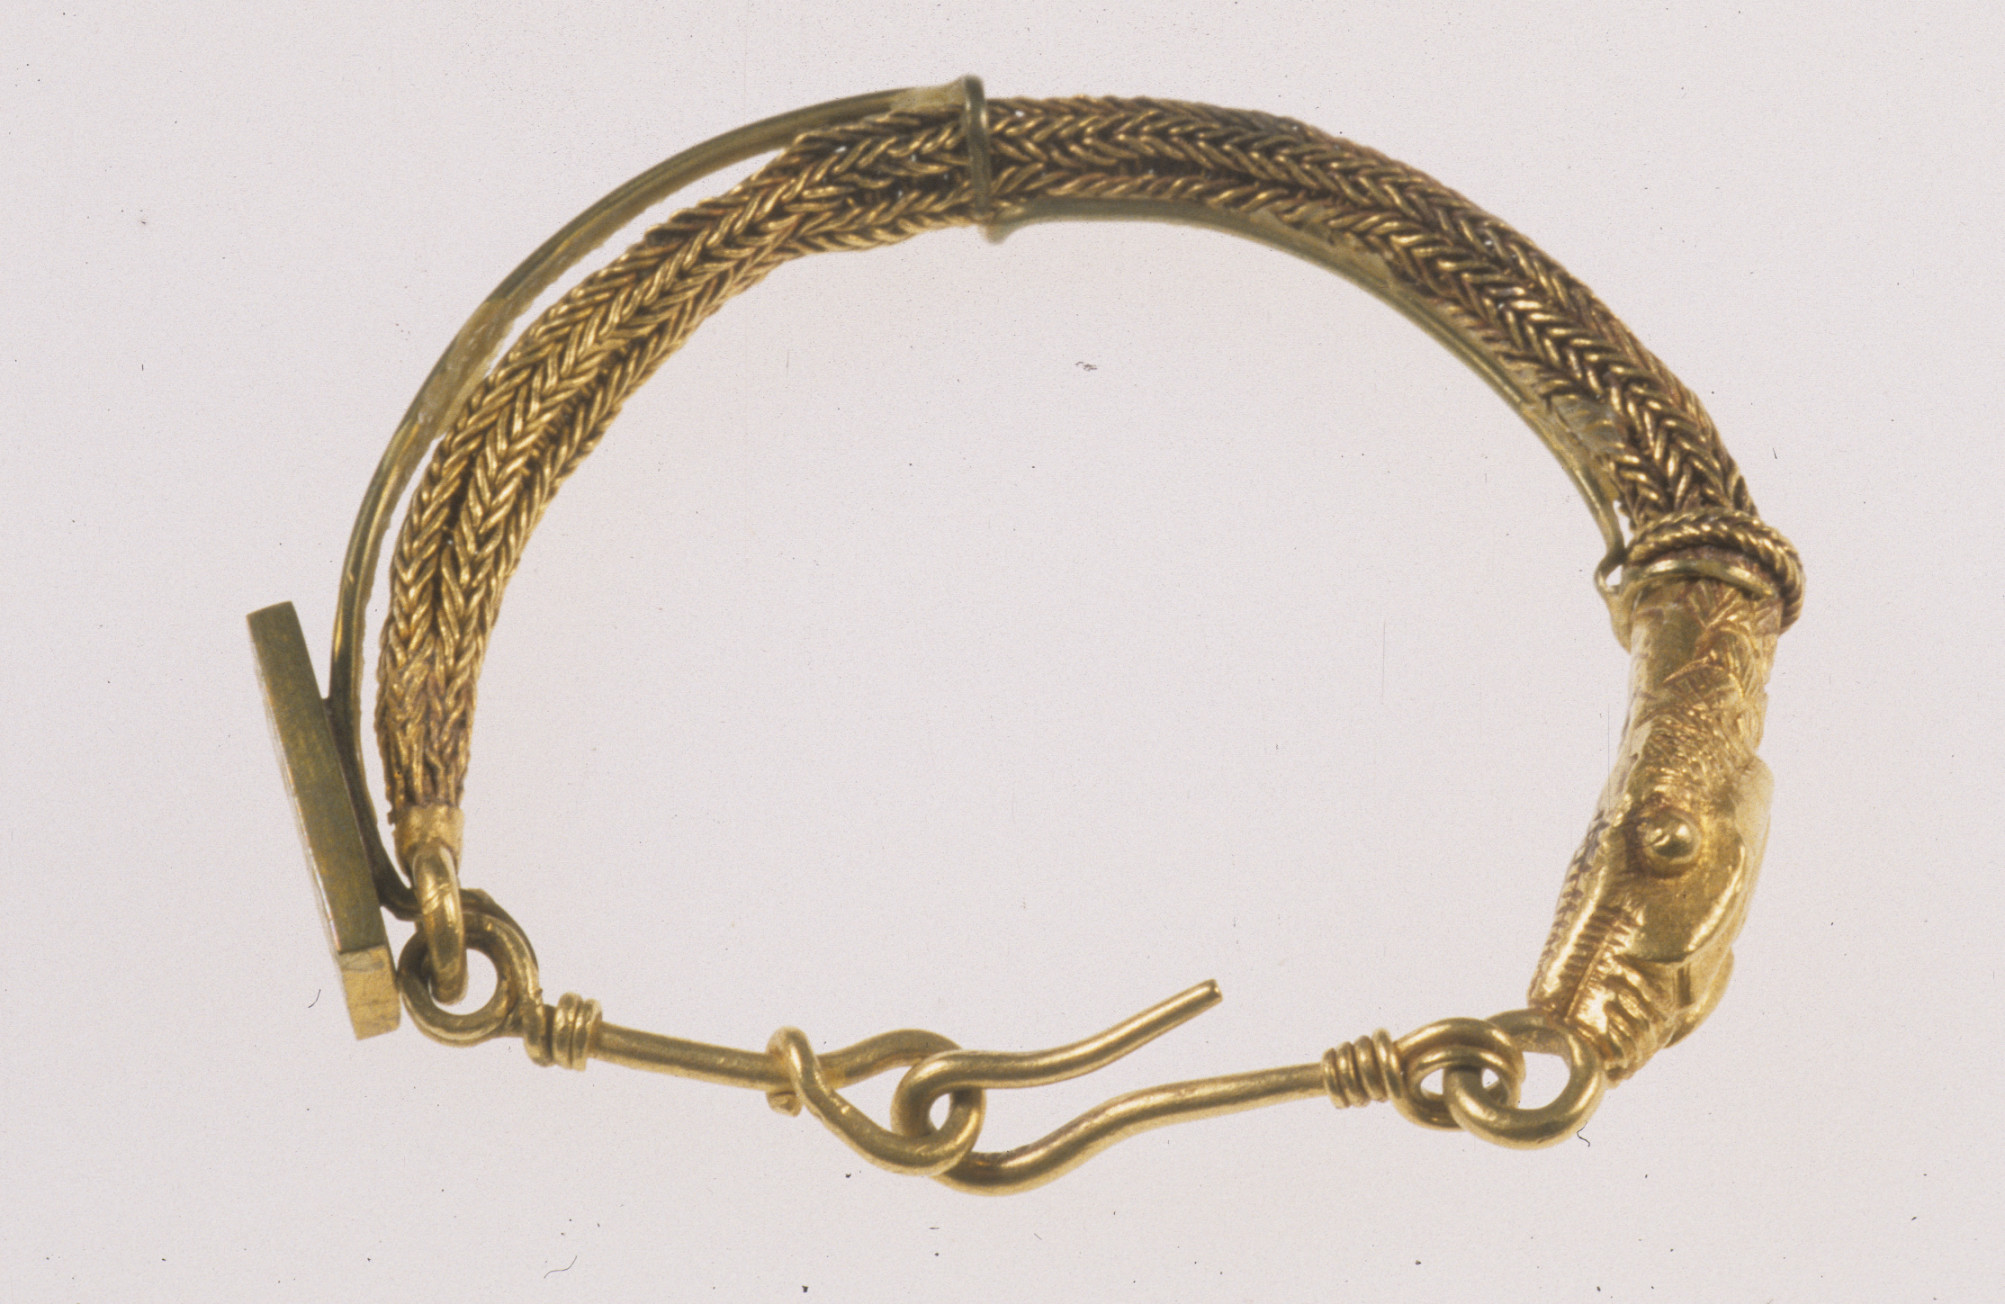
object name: bracelet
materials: gold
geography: egypt